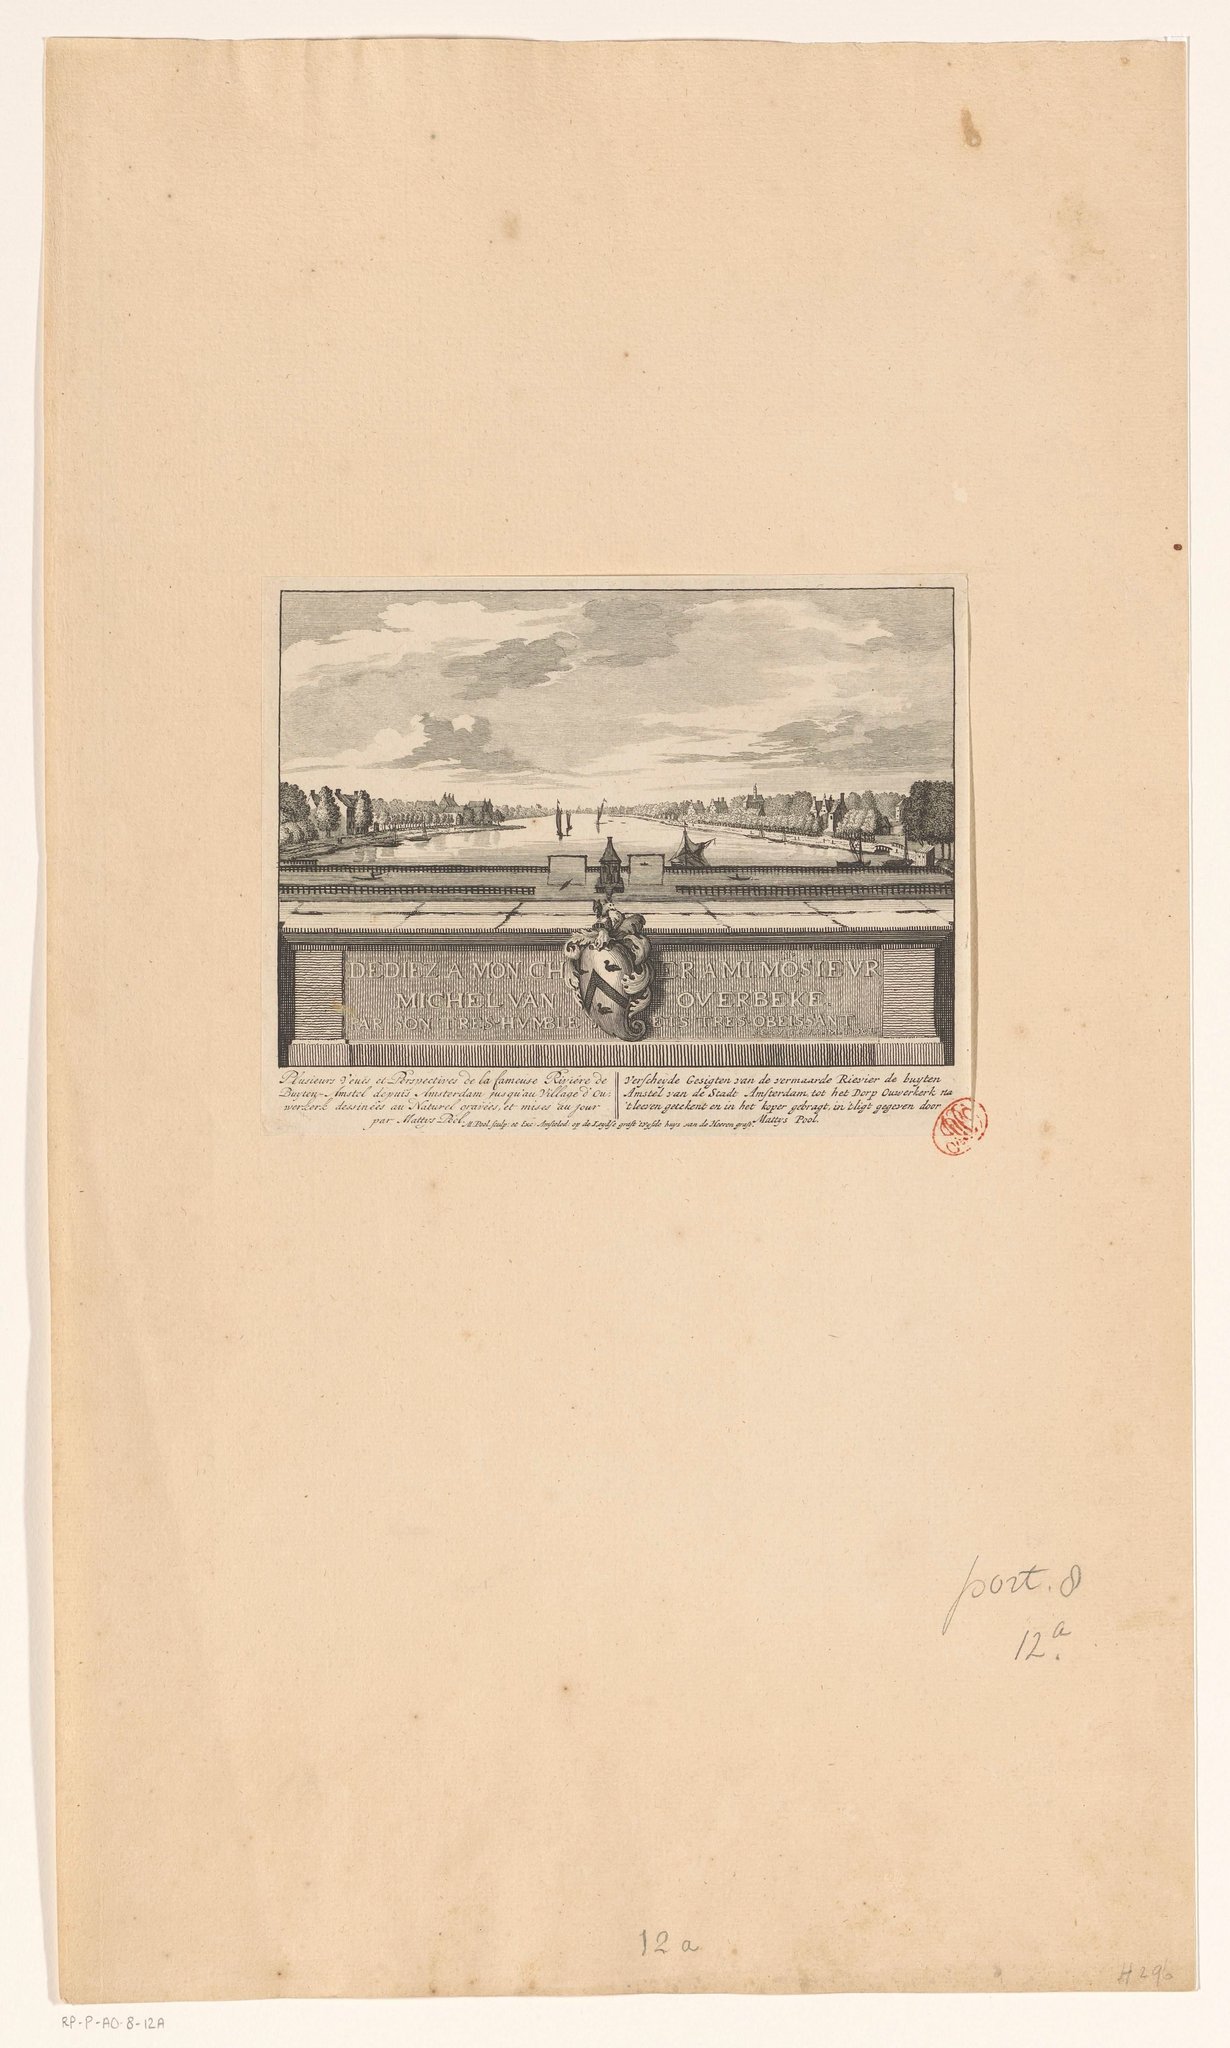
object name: print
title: Titelprent voor: Verscheyde gesigten van de vermaarde rievier de buyten Amstel (...)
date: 1708-1740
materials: paper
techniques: engraving, etching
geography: amsterdam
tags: sailing-ship, sailing-boat, river, rowing-boat, canoe, etc., armorial bearing, heraldry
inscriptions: collector's mark: Lugt 2233, collector's mark: Lugt 195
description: Prent gebruikt in: Pool, Matthijs. Verscheyde gesigten van de vermaarde rievier de buyten Amstel van de stadt Amsterdam, tot het dorp Ouwerkerk (…) / Plusieurs veuës et perspectives de la fameuse riviére de Buyten-Amstel depuis Amsterdam jusqu'au village d'Ouwerkerk (…). Amsterdam: Matthijs Pool, z.j. [1708-1740].